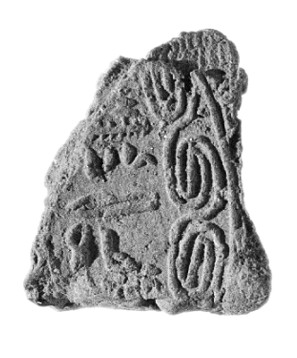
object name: sealing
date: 1981-1640 BCE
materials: mud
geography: egypt